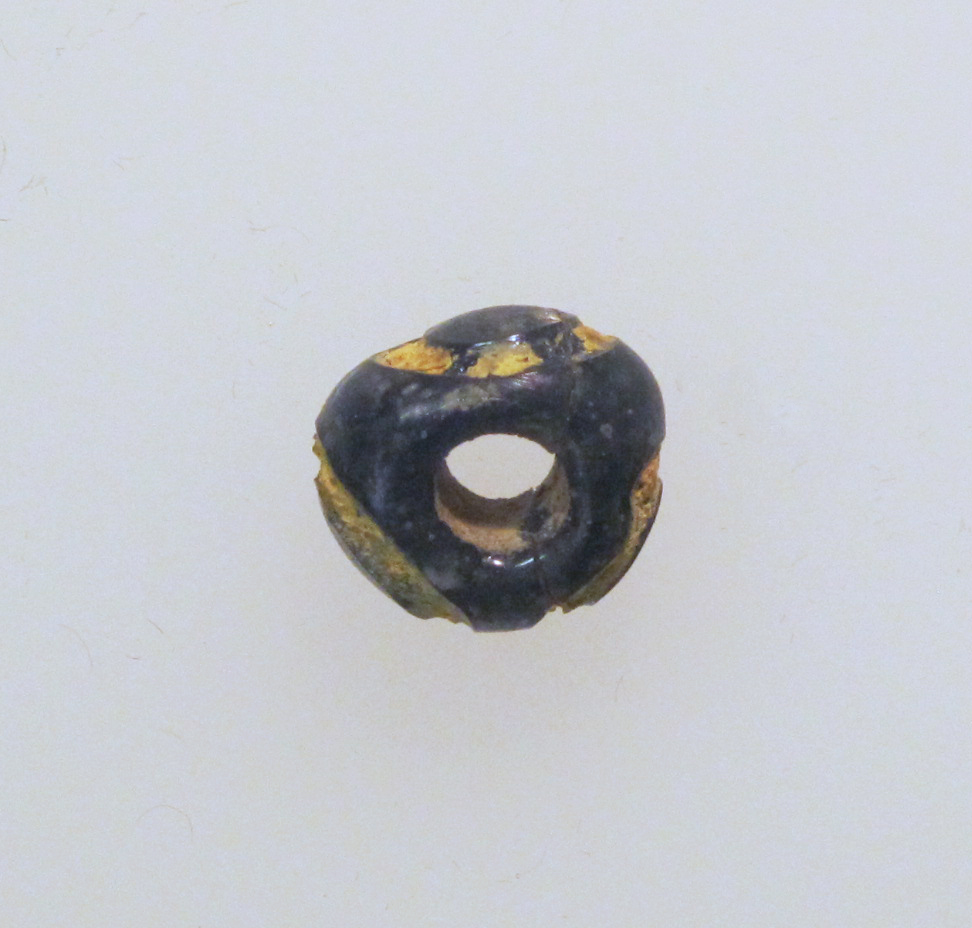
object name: bead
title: Glass eye bead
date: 7000 BCE-330 CE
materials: glass